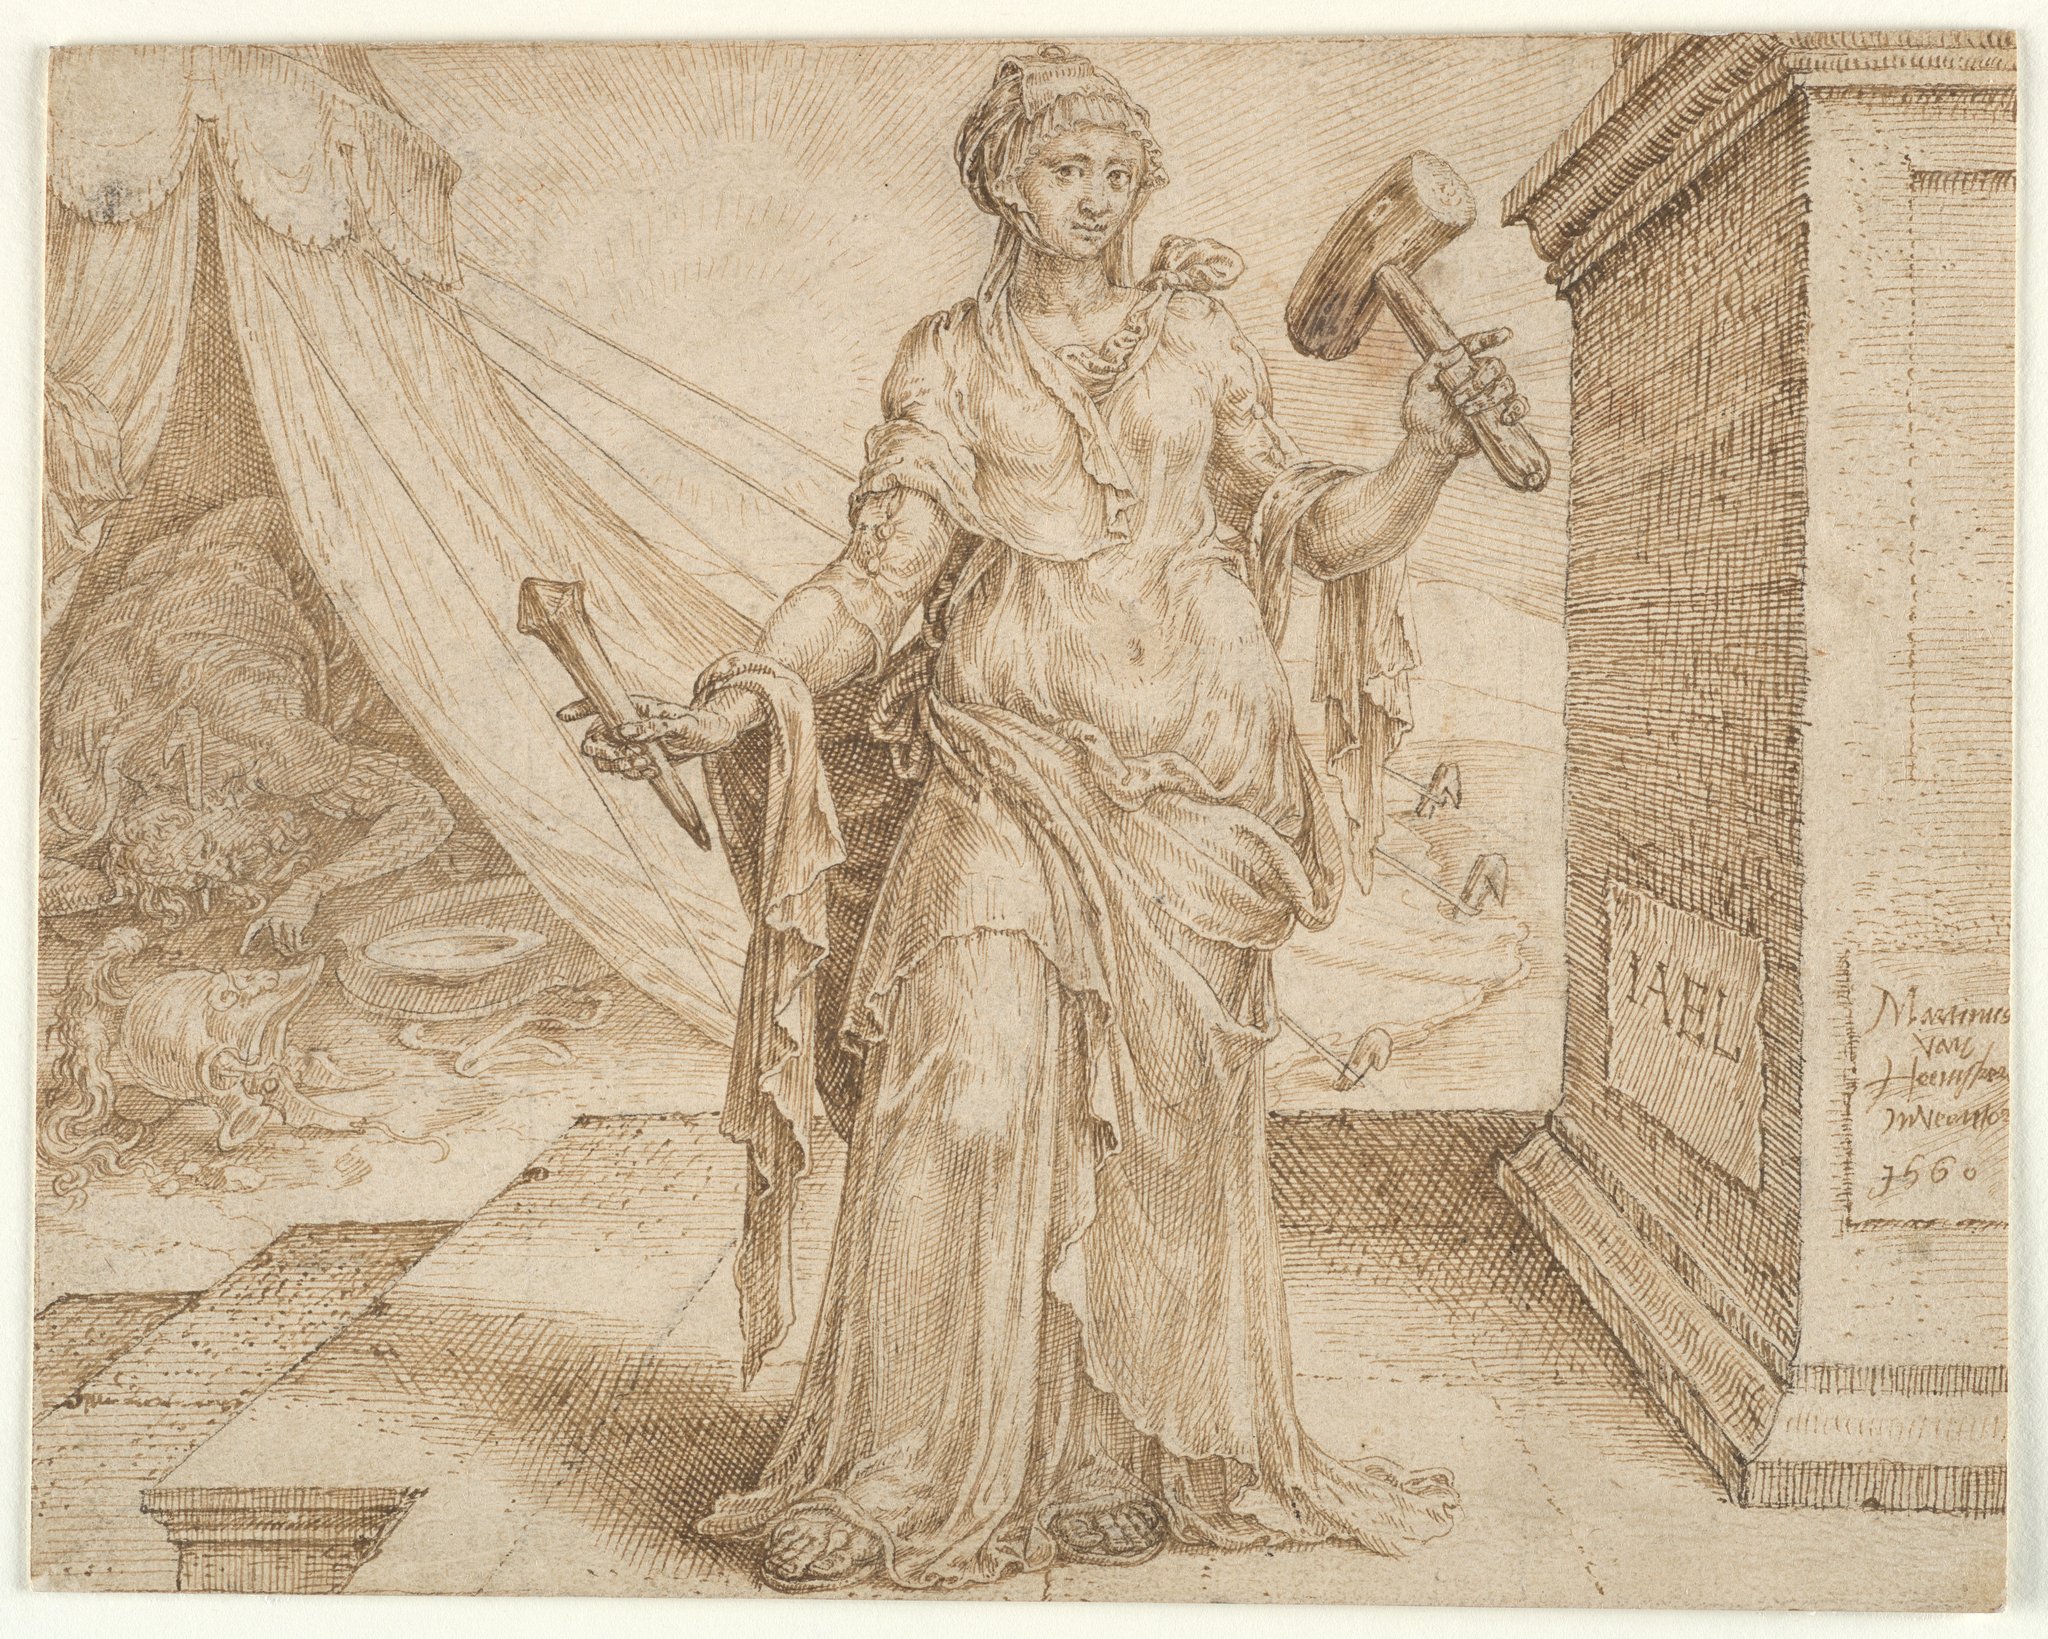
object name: drawing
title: Jael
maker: maarten van heemskerck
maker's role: artist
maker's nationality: netherlandish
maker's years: 1498-1574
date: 1560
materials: chalk, ink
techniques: pen, transfer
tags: men,women,death,hammers